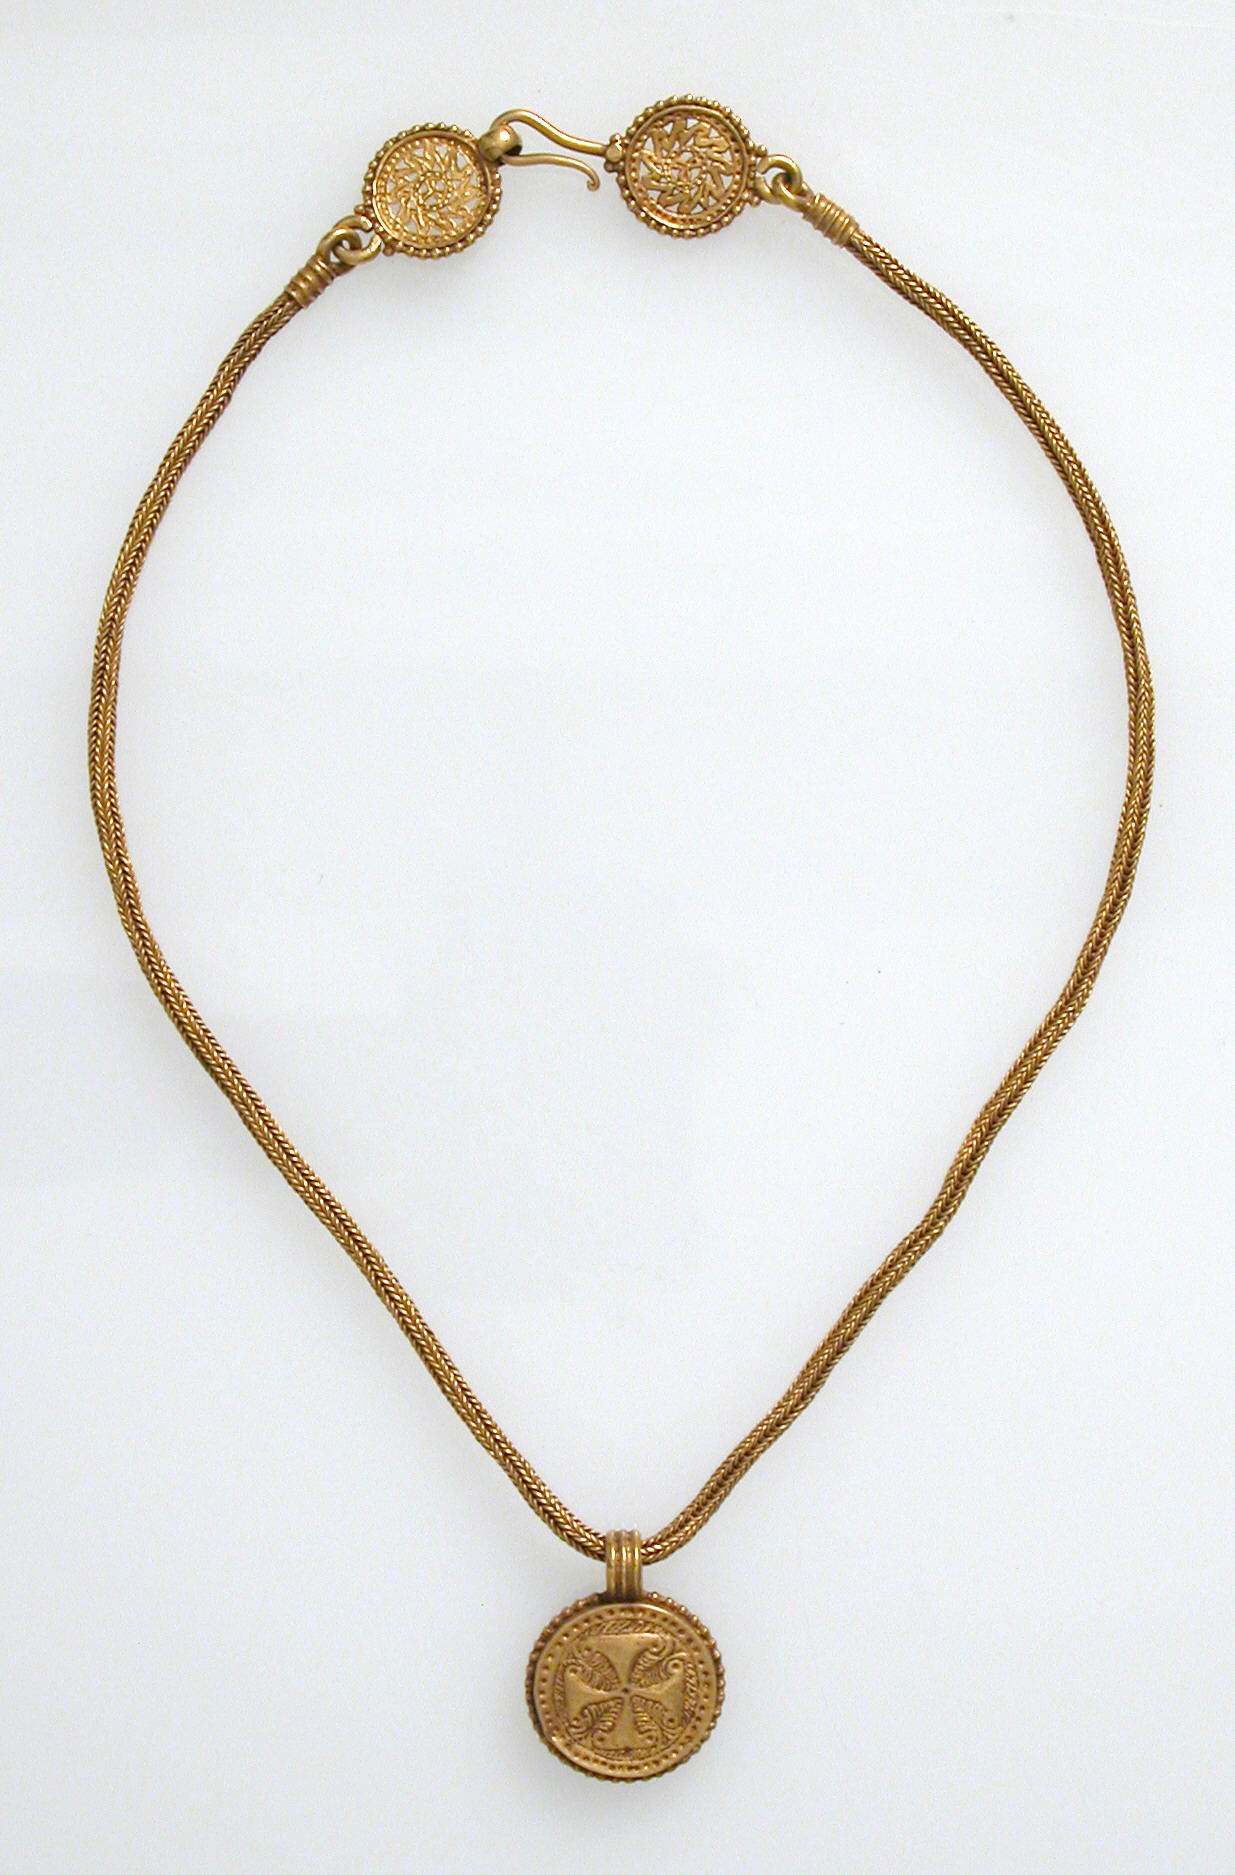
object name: necklace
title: Gold Necklace with Pendant Cross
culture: byzantine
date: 501-700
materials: gold